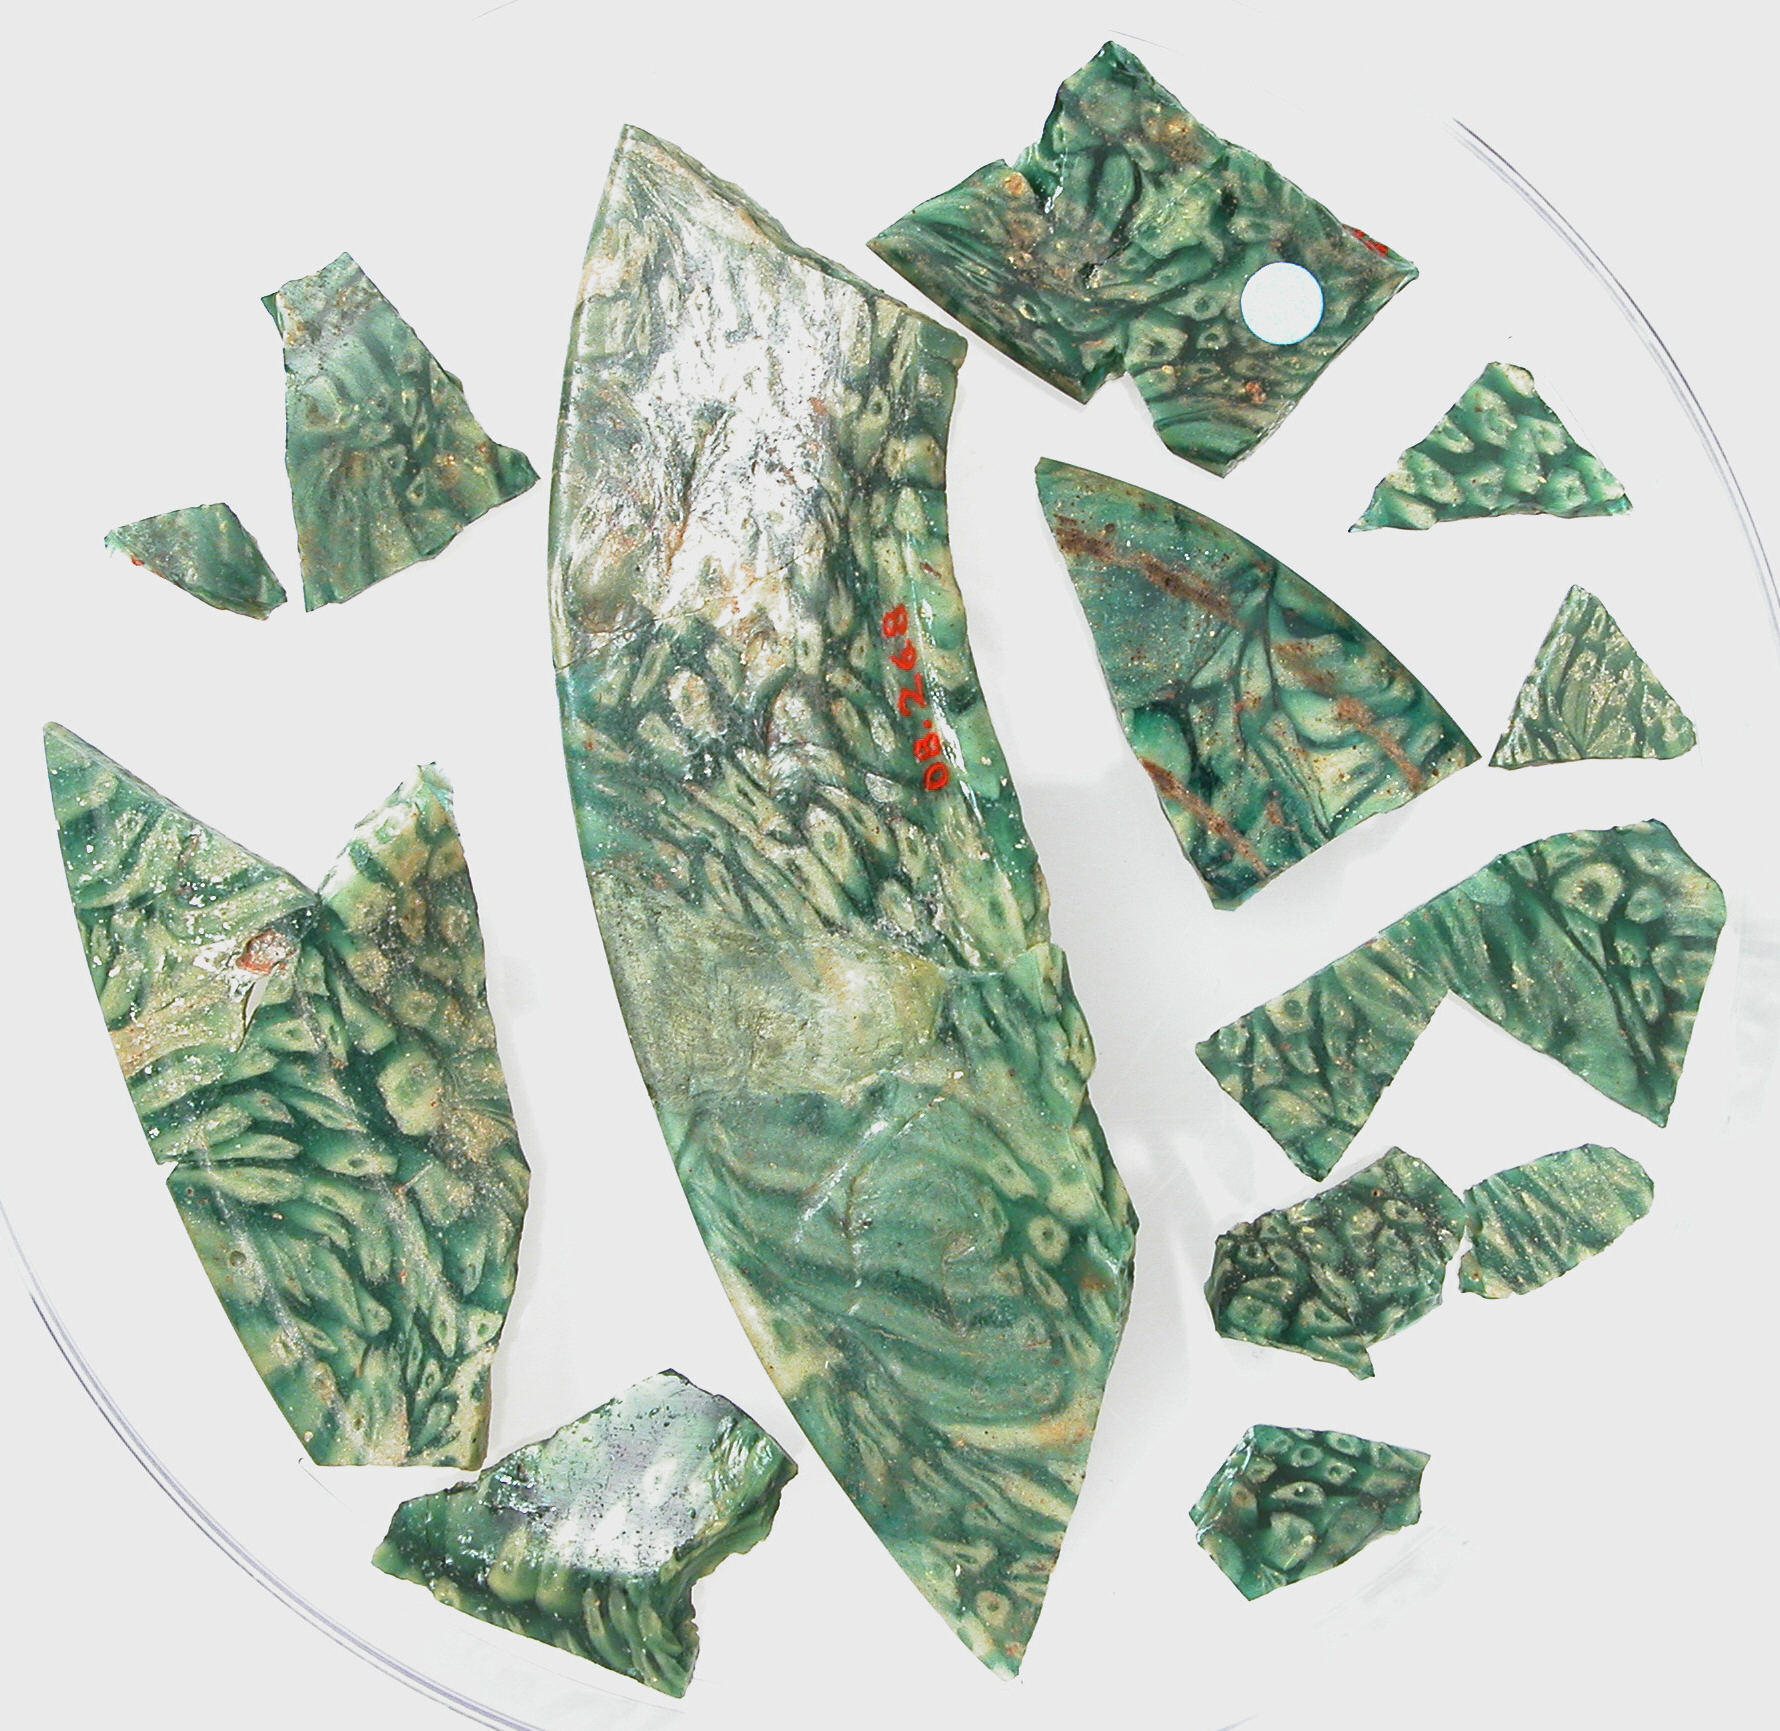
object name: fragment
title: Glass Fragments from a Vessel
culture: coptic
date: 301-433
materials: glass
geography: egypt